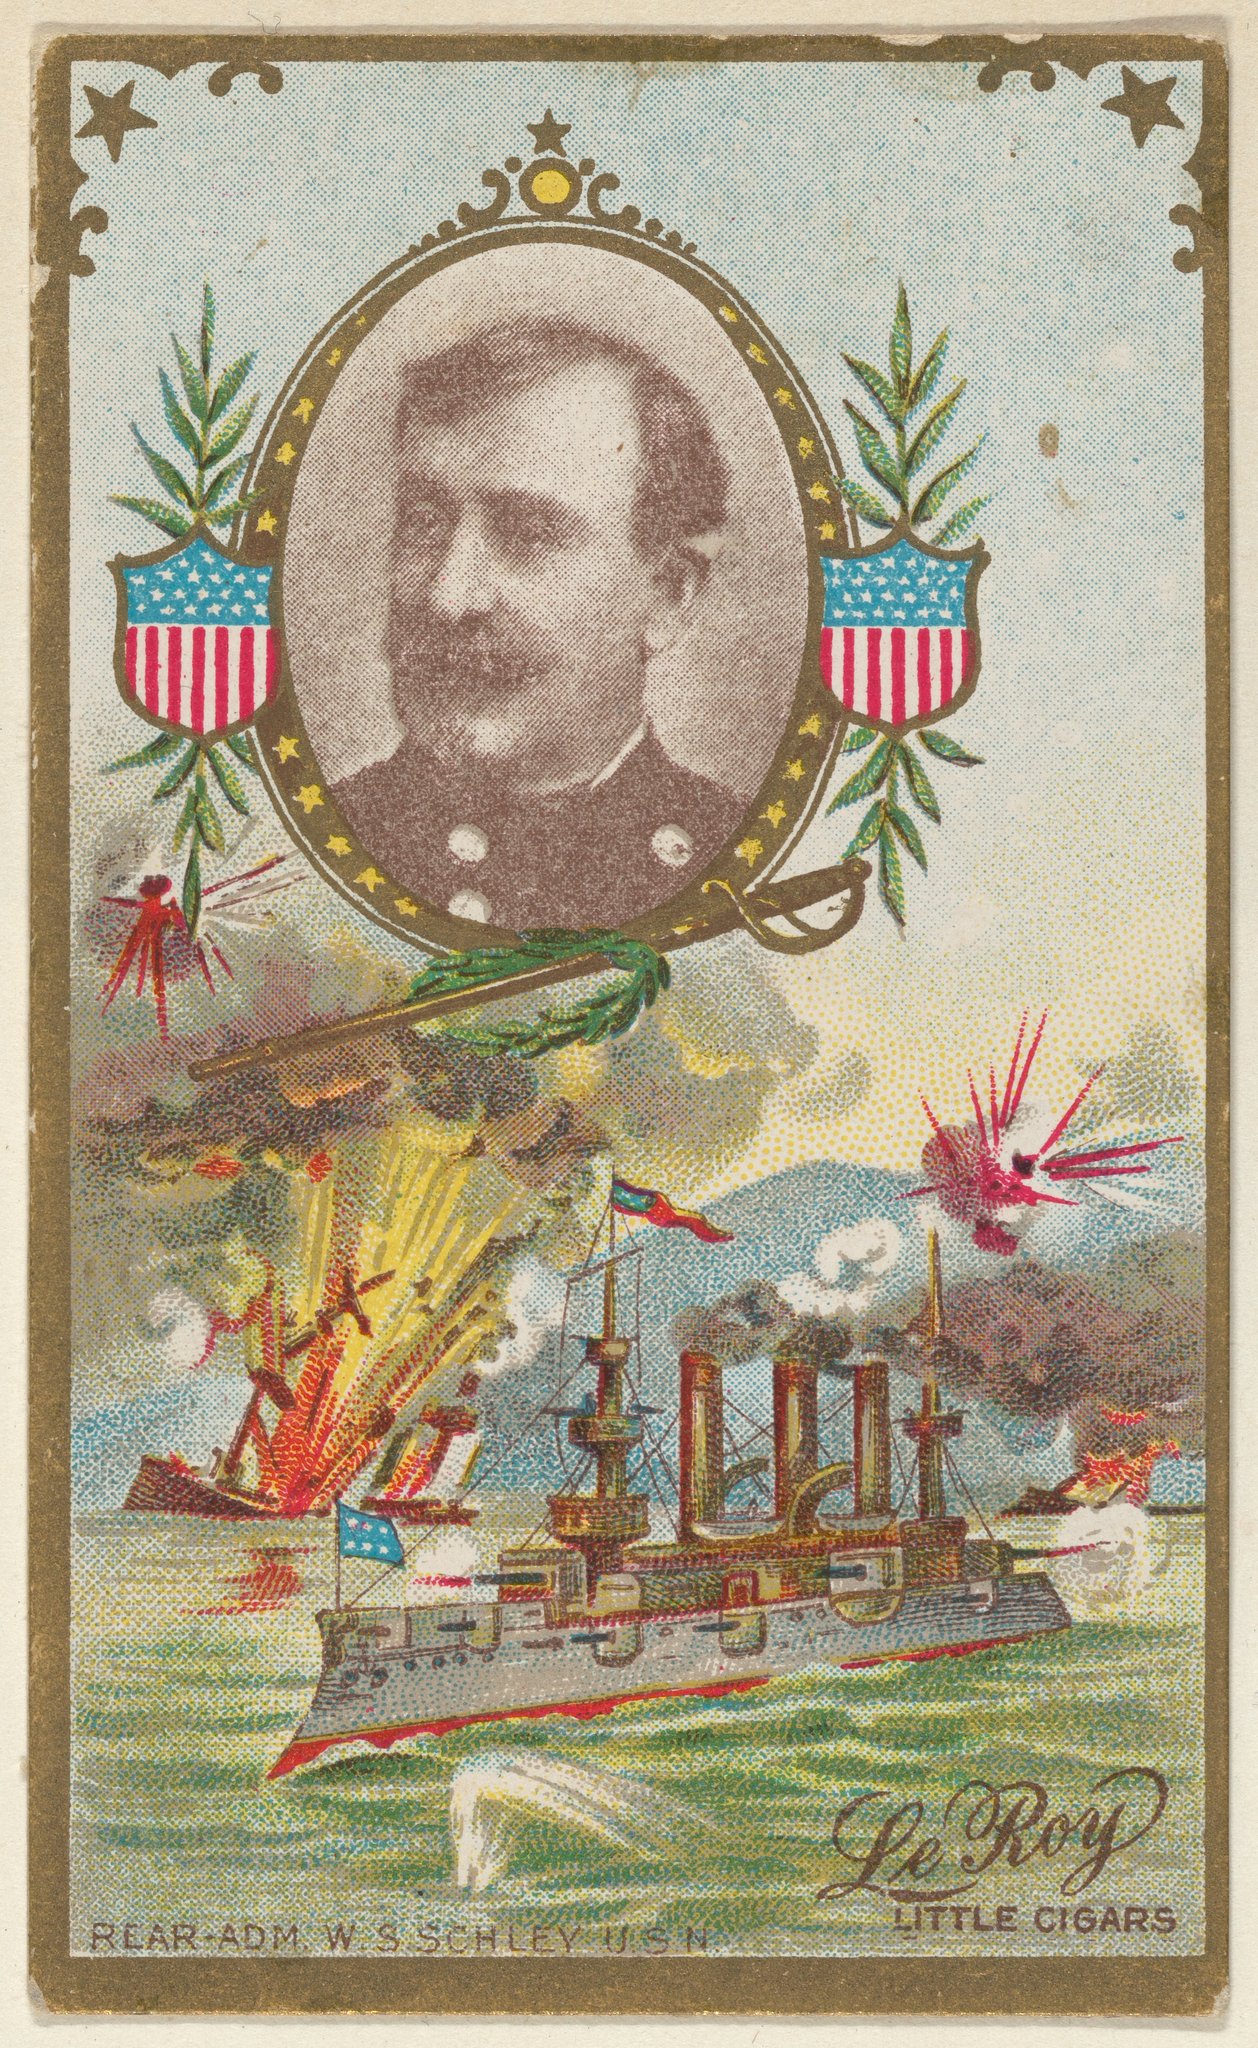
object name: print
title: Real Admiral Winfield S. Schley, U.S. Navy, from the "Generals" series (T63), issued by LeRoy Little Cigars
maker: leroy little cigars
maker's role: publisher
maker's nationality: american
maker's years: 1850-1950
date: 1898-1901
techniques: color lithograph